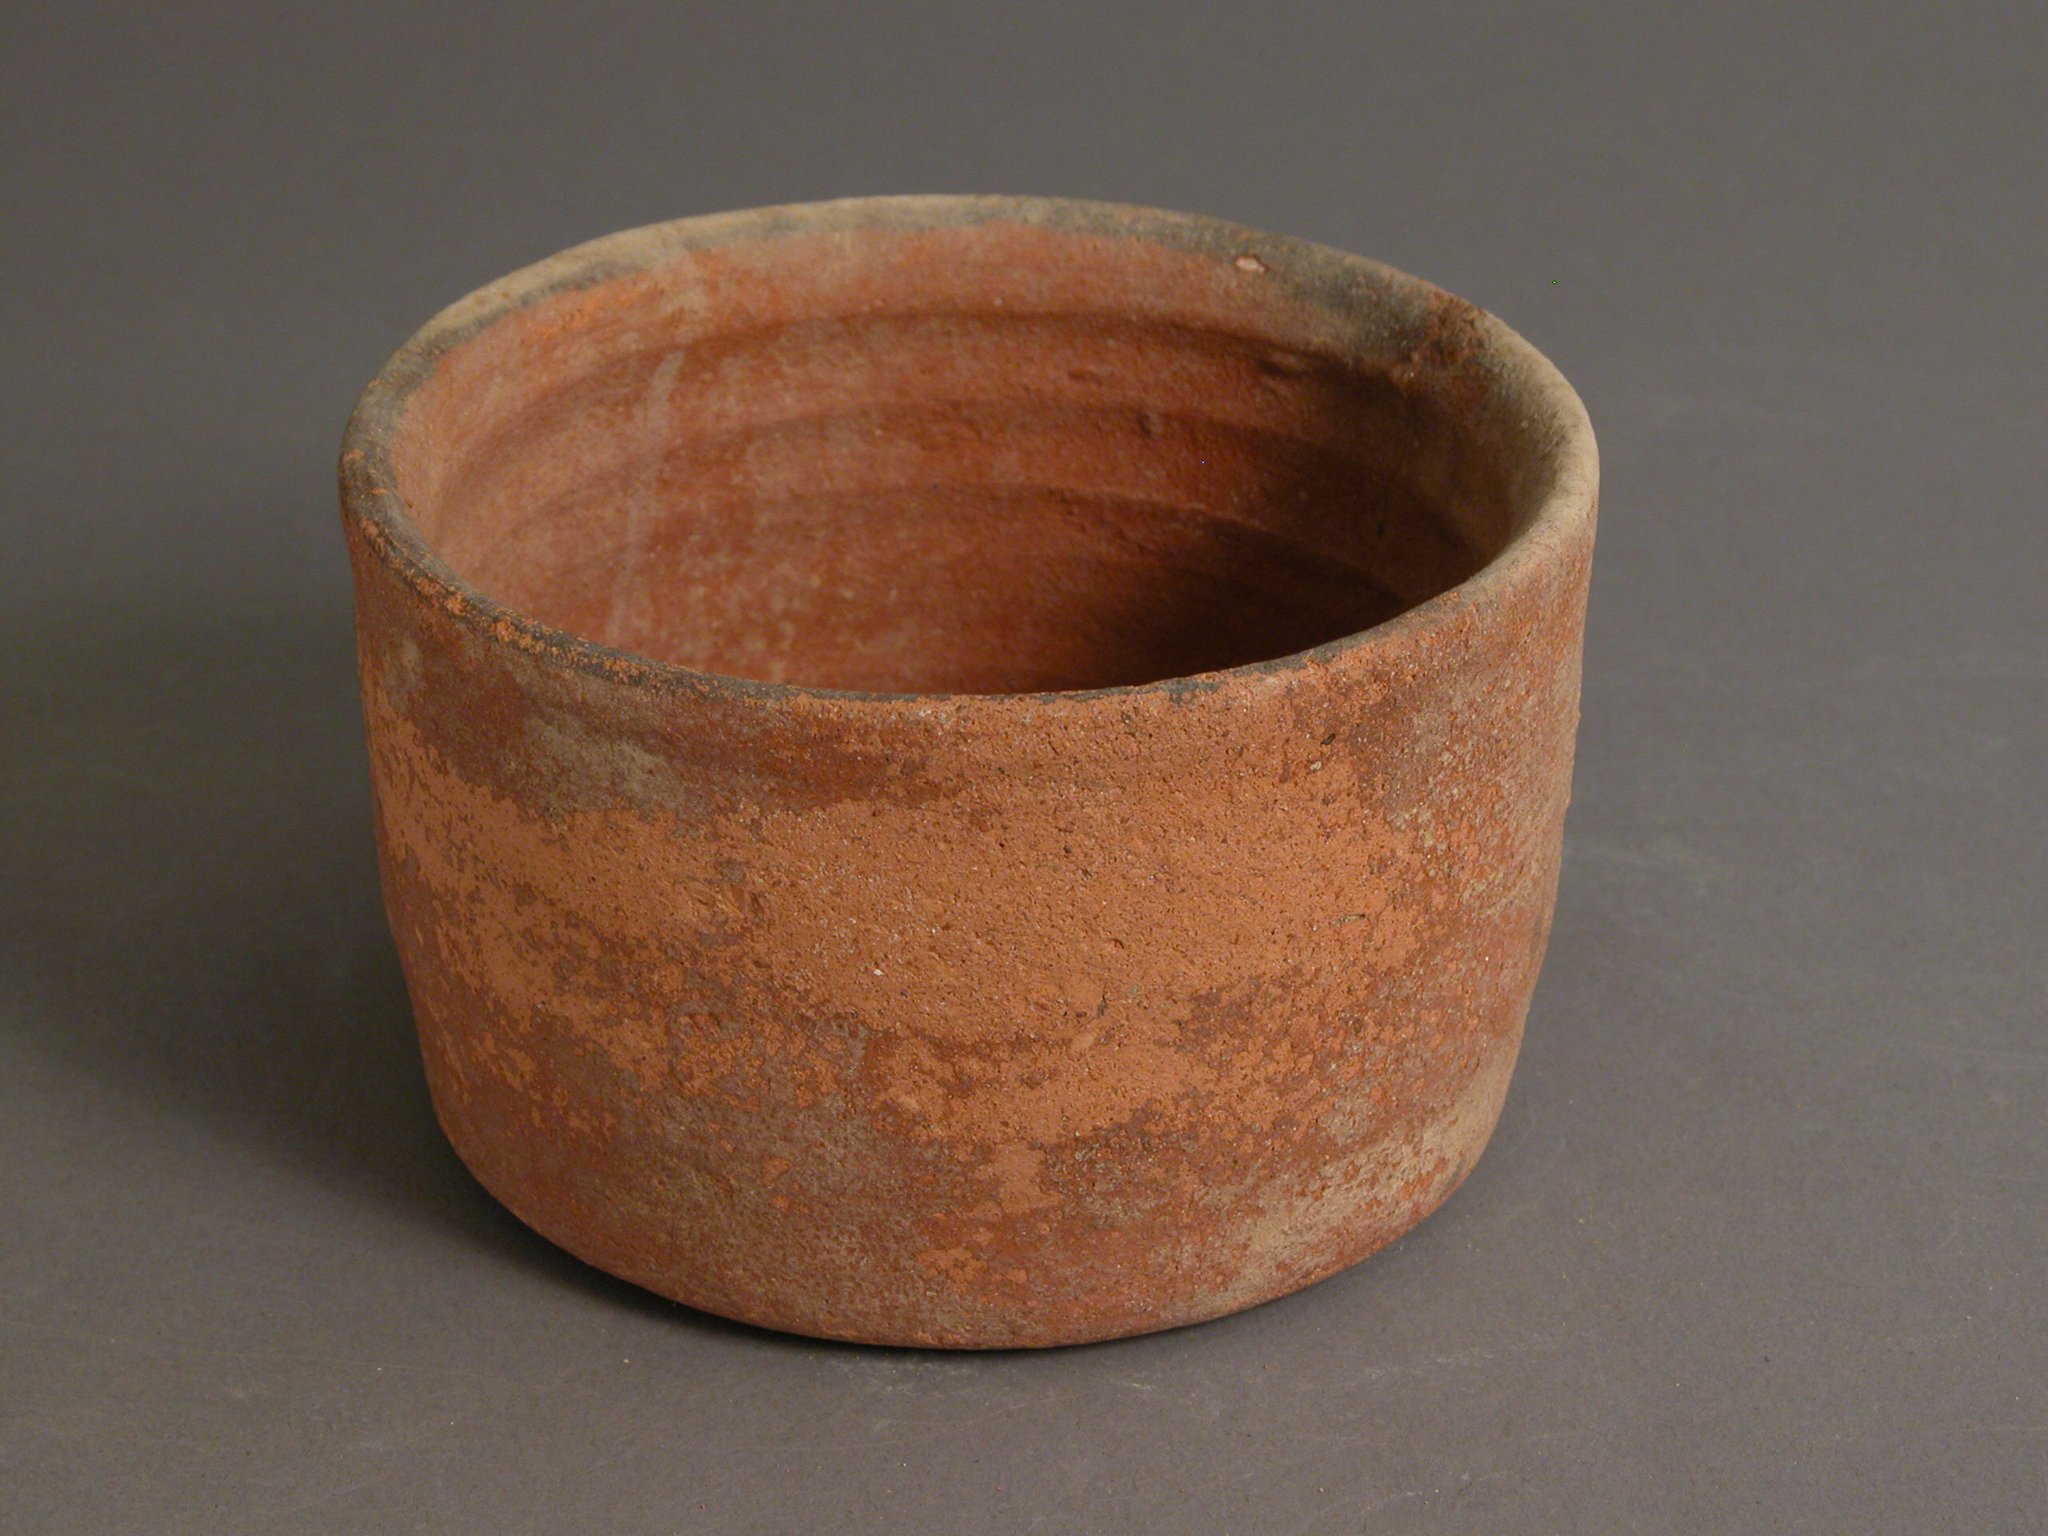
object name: bowl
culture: coptic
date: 301-700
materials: earthenware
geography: egypt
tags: bowls